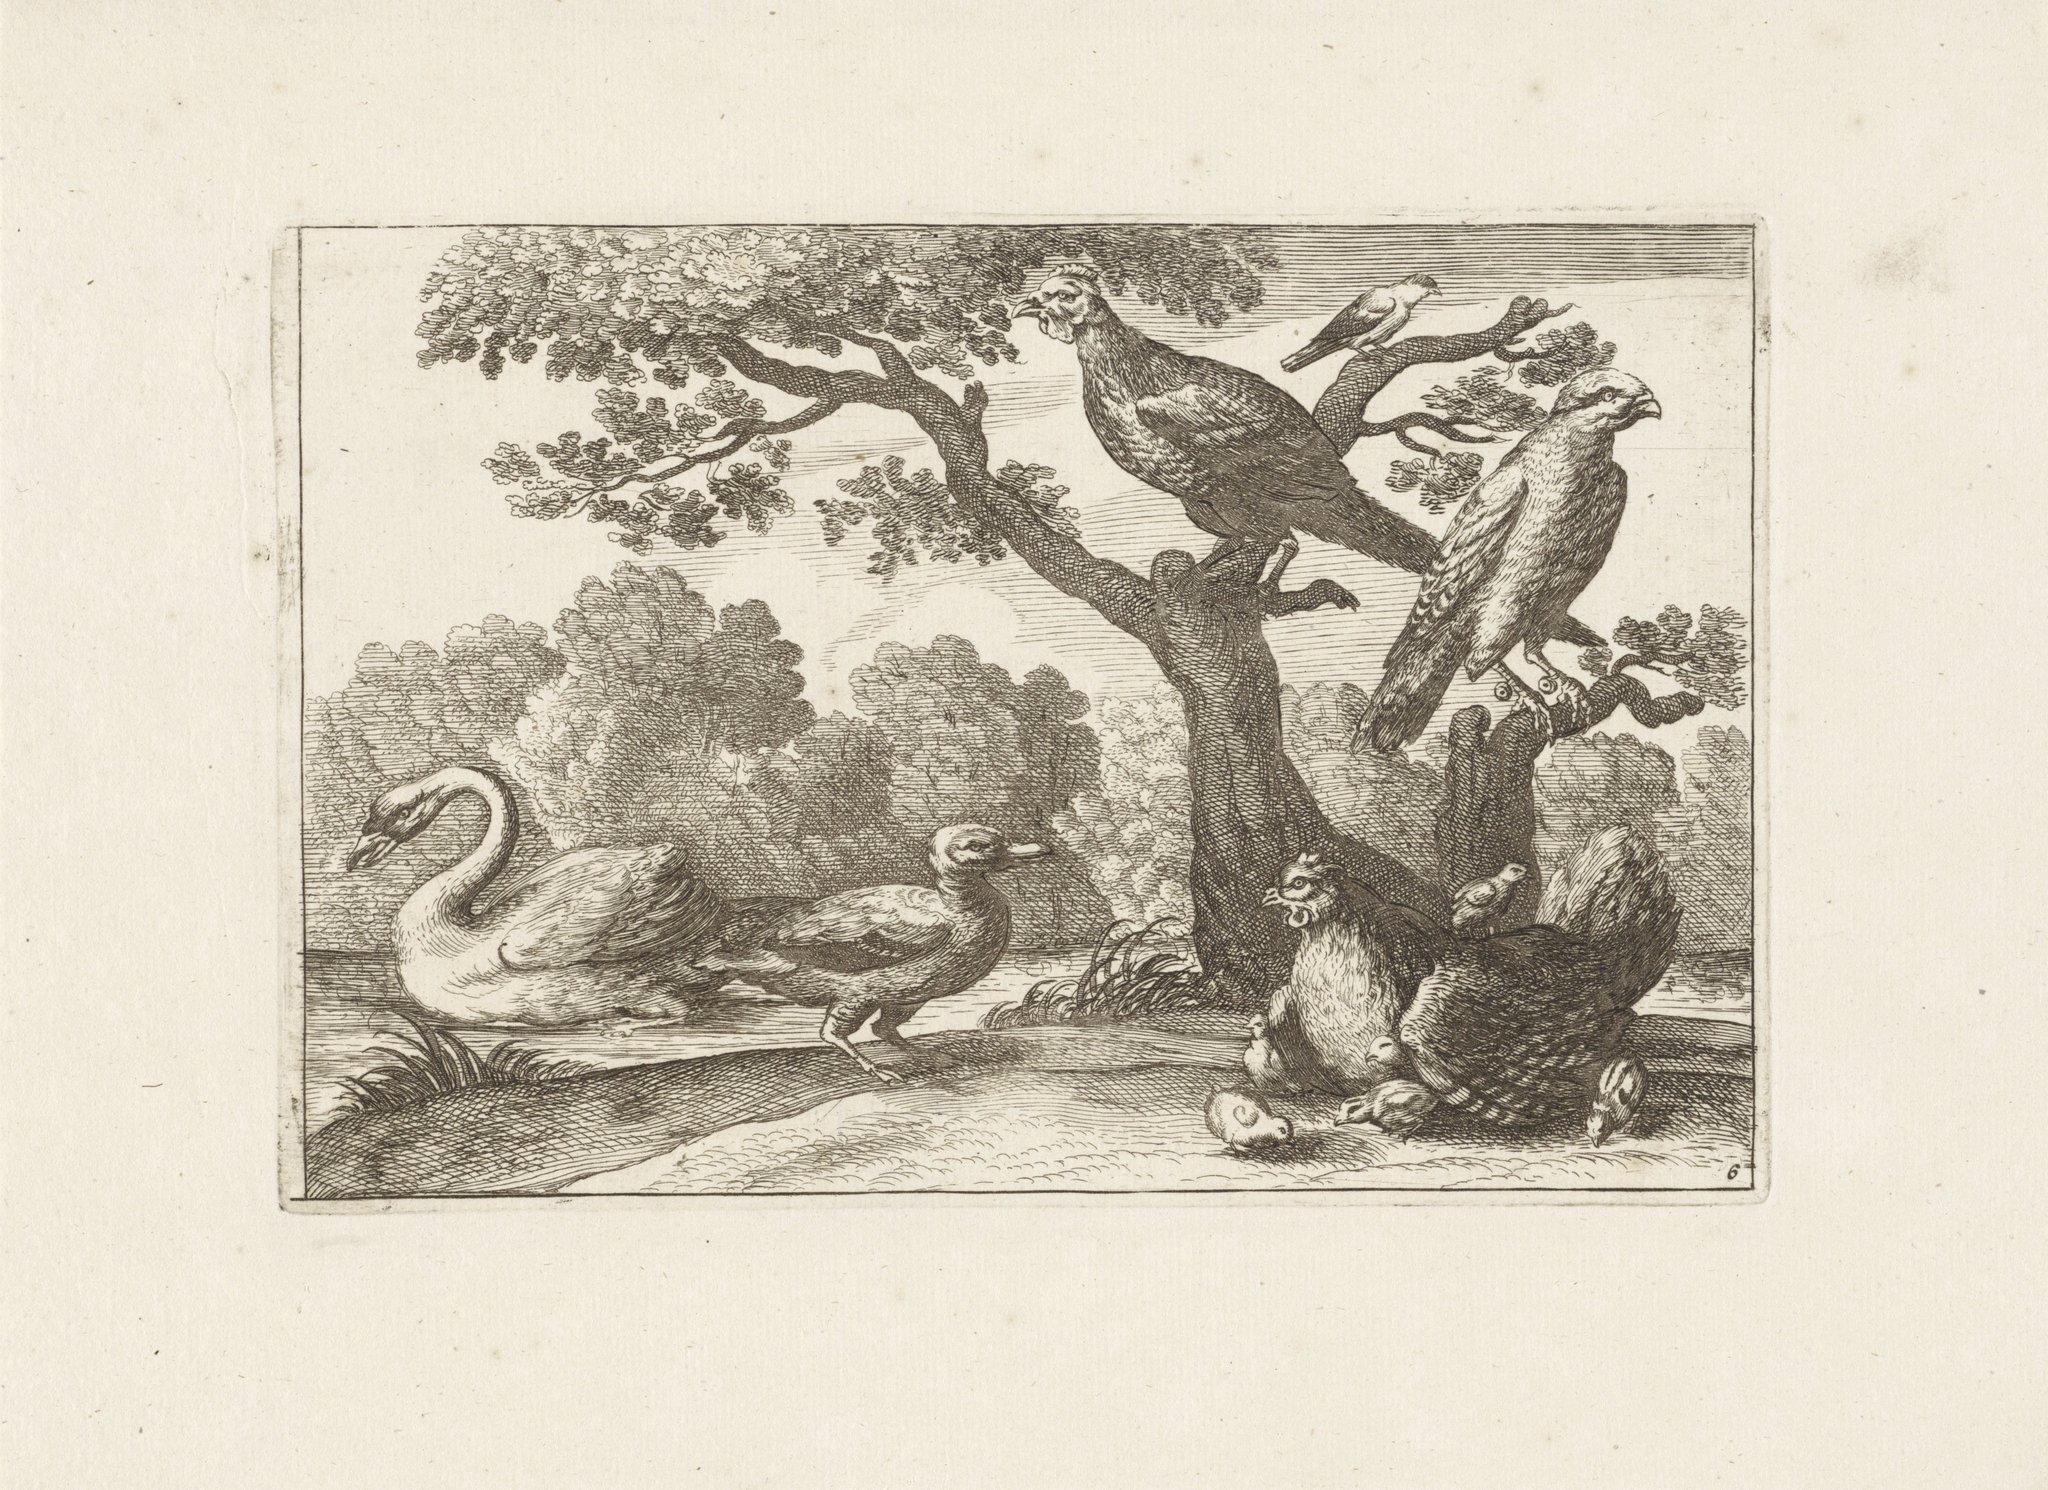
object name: print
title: Kip met kuikens en andere vogels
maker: pieter schenk (i)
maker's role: print maker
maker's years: 1660-1711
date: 1675-1711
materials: paper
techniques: etching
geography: amsterdam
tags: birds, fowl (cock, hen, chicken, etc.)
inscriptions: number: ‘6’, collector's mark: Lugt 2228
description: Kip met kuikens, zittend onder een boom. Drie vogels in de boom. Een zwaan in het water links.